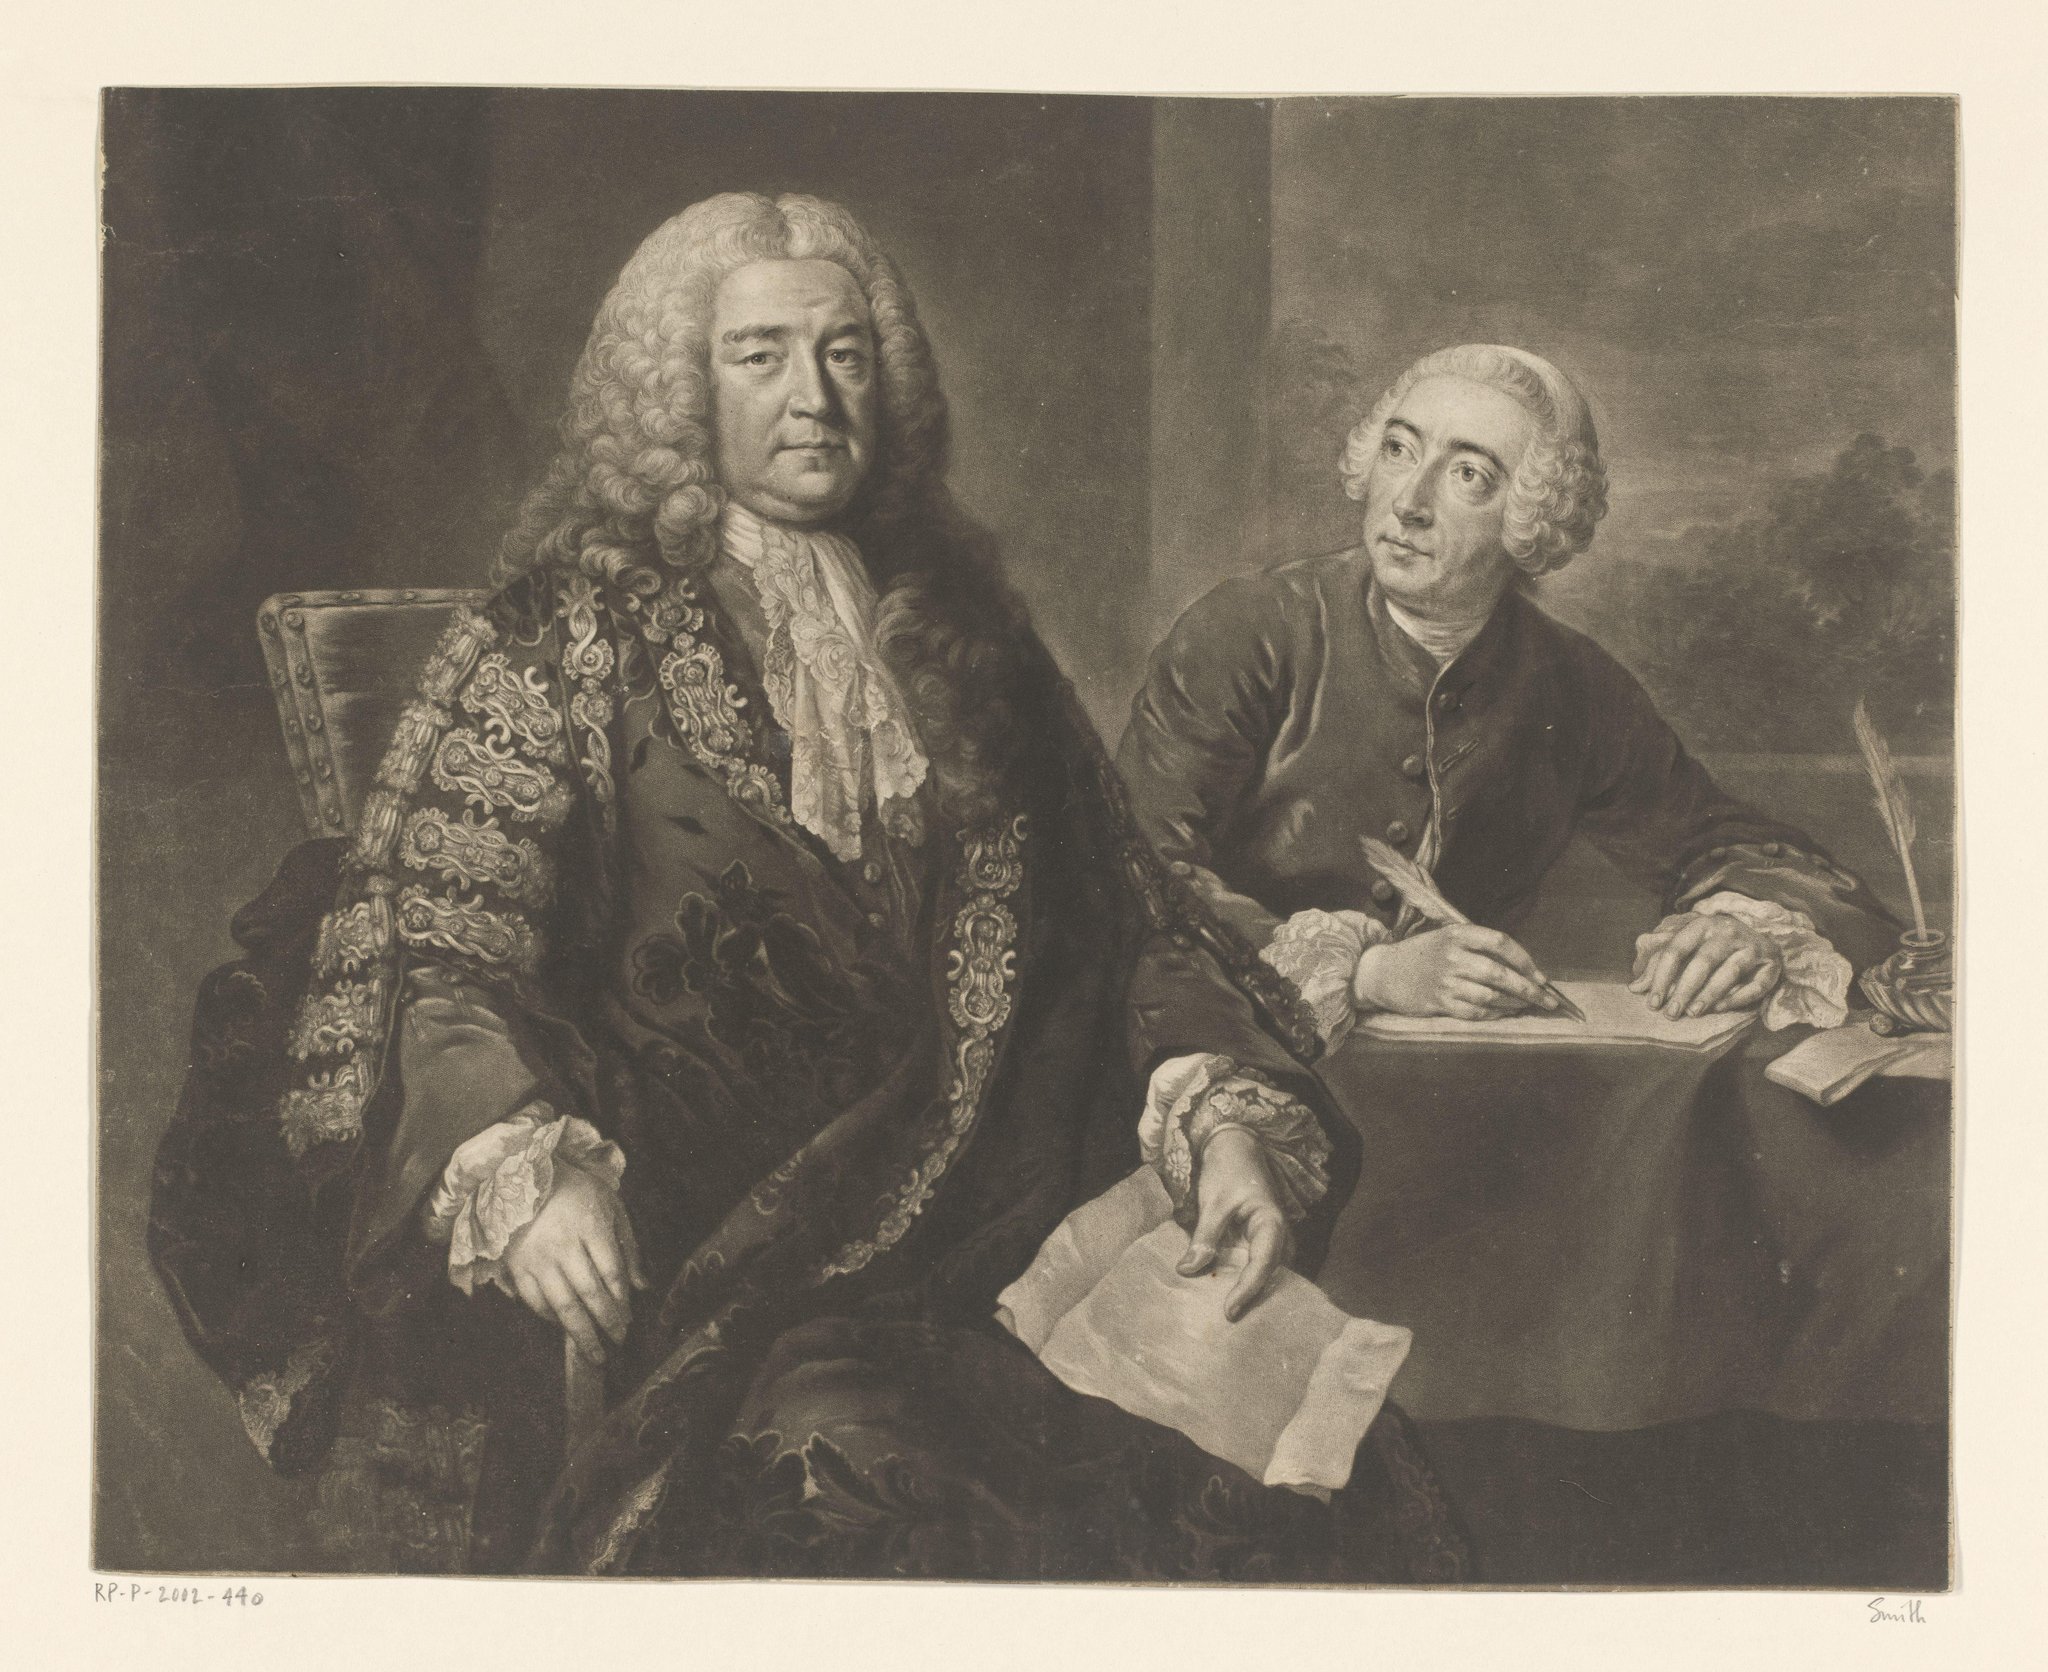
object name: print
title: Dubbelportret van Henry Pelham en John Roberts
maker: richard houston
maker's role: print maker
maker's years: 1721-1775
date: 1752-1775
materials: paper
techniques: mezzotint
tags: london, politician, prime minister, writing tools, historical persons, secretary, scribe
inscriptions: collector's mark: Lugt 2228, collector's mark: Lugt 2760